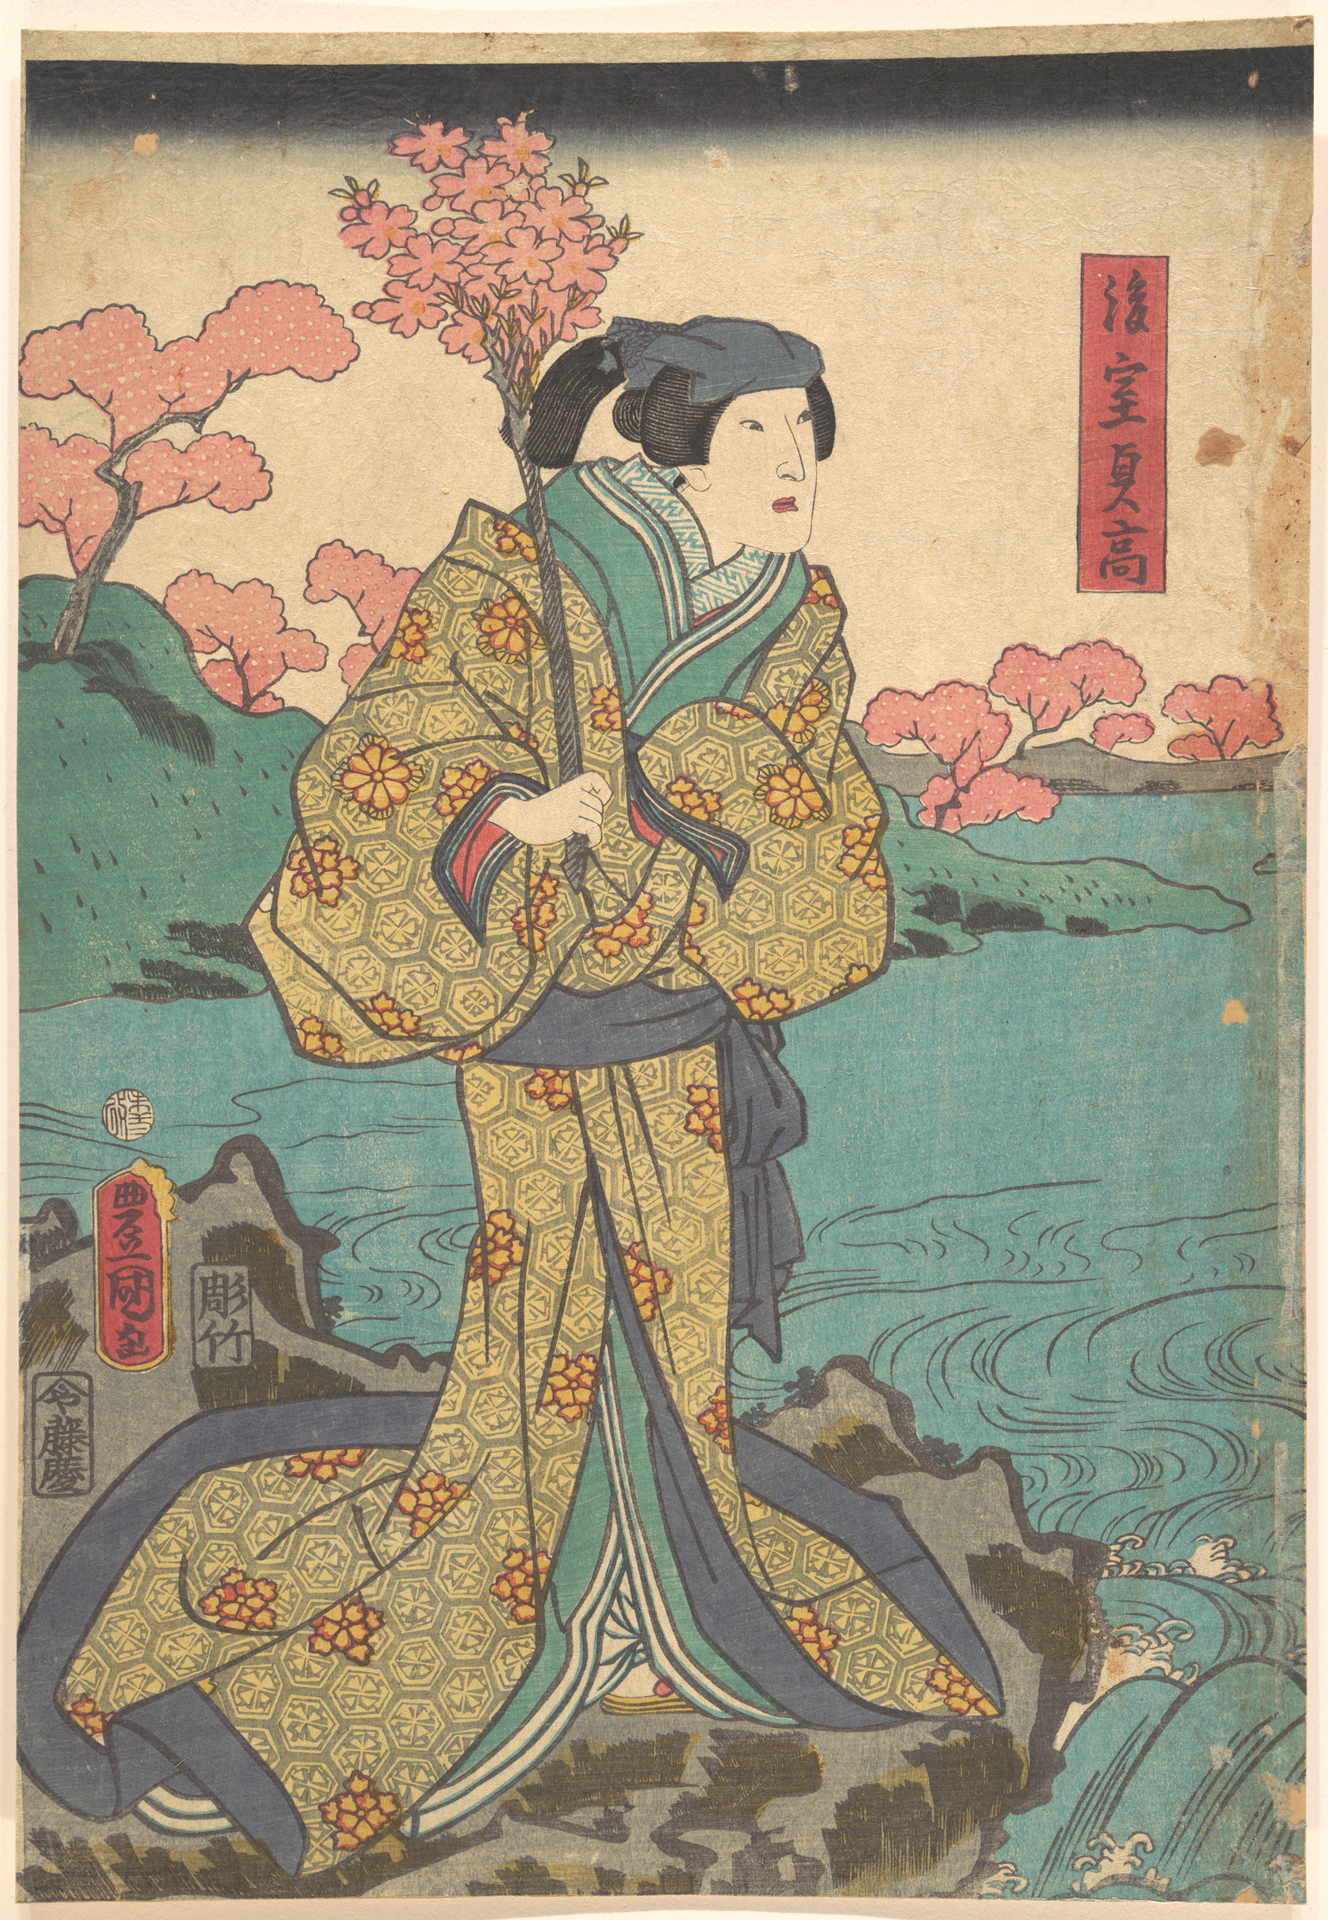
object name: print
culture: japanese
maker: utagawa kunisada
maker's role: artist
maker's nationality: japanese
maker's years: 1786-1864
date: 1786-1854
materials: ink, paper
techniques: woodblock print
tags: human figures